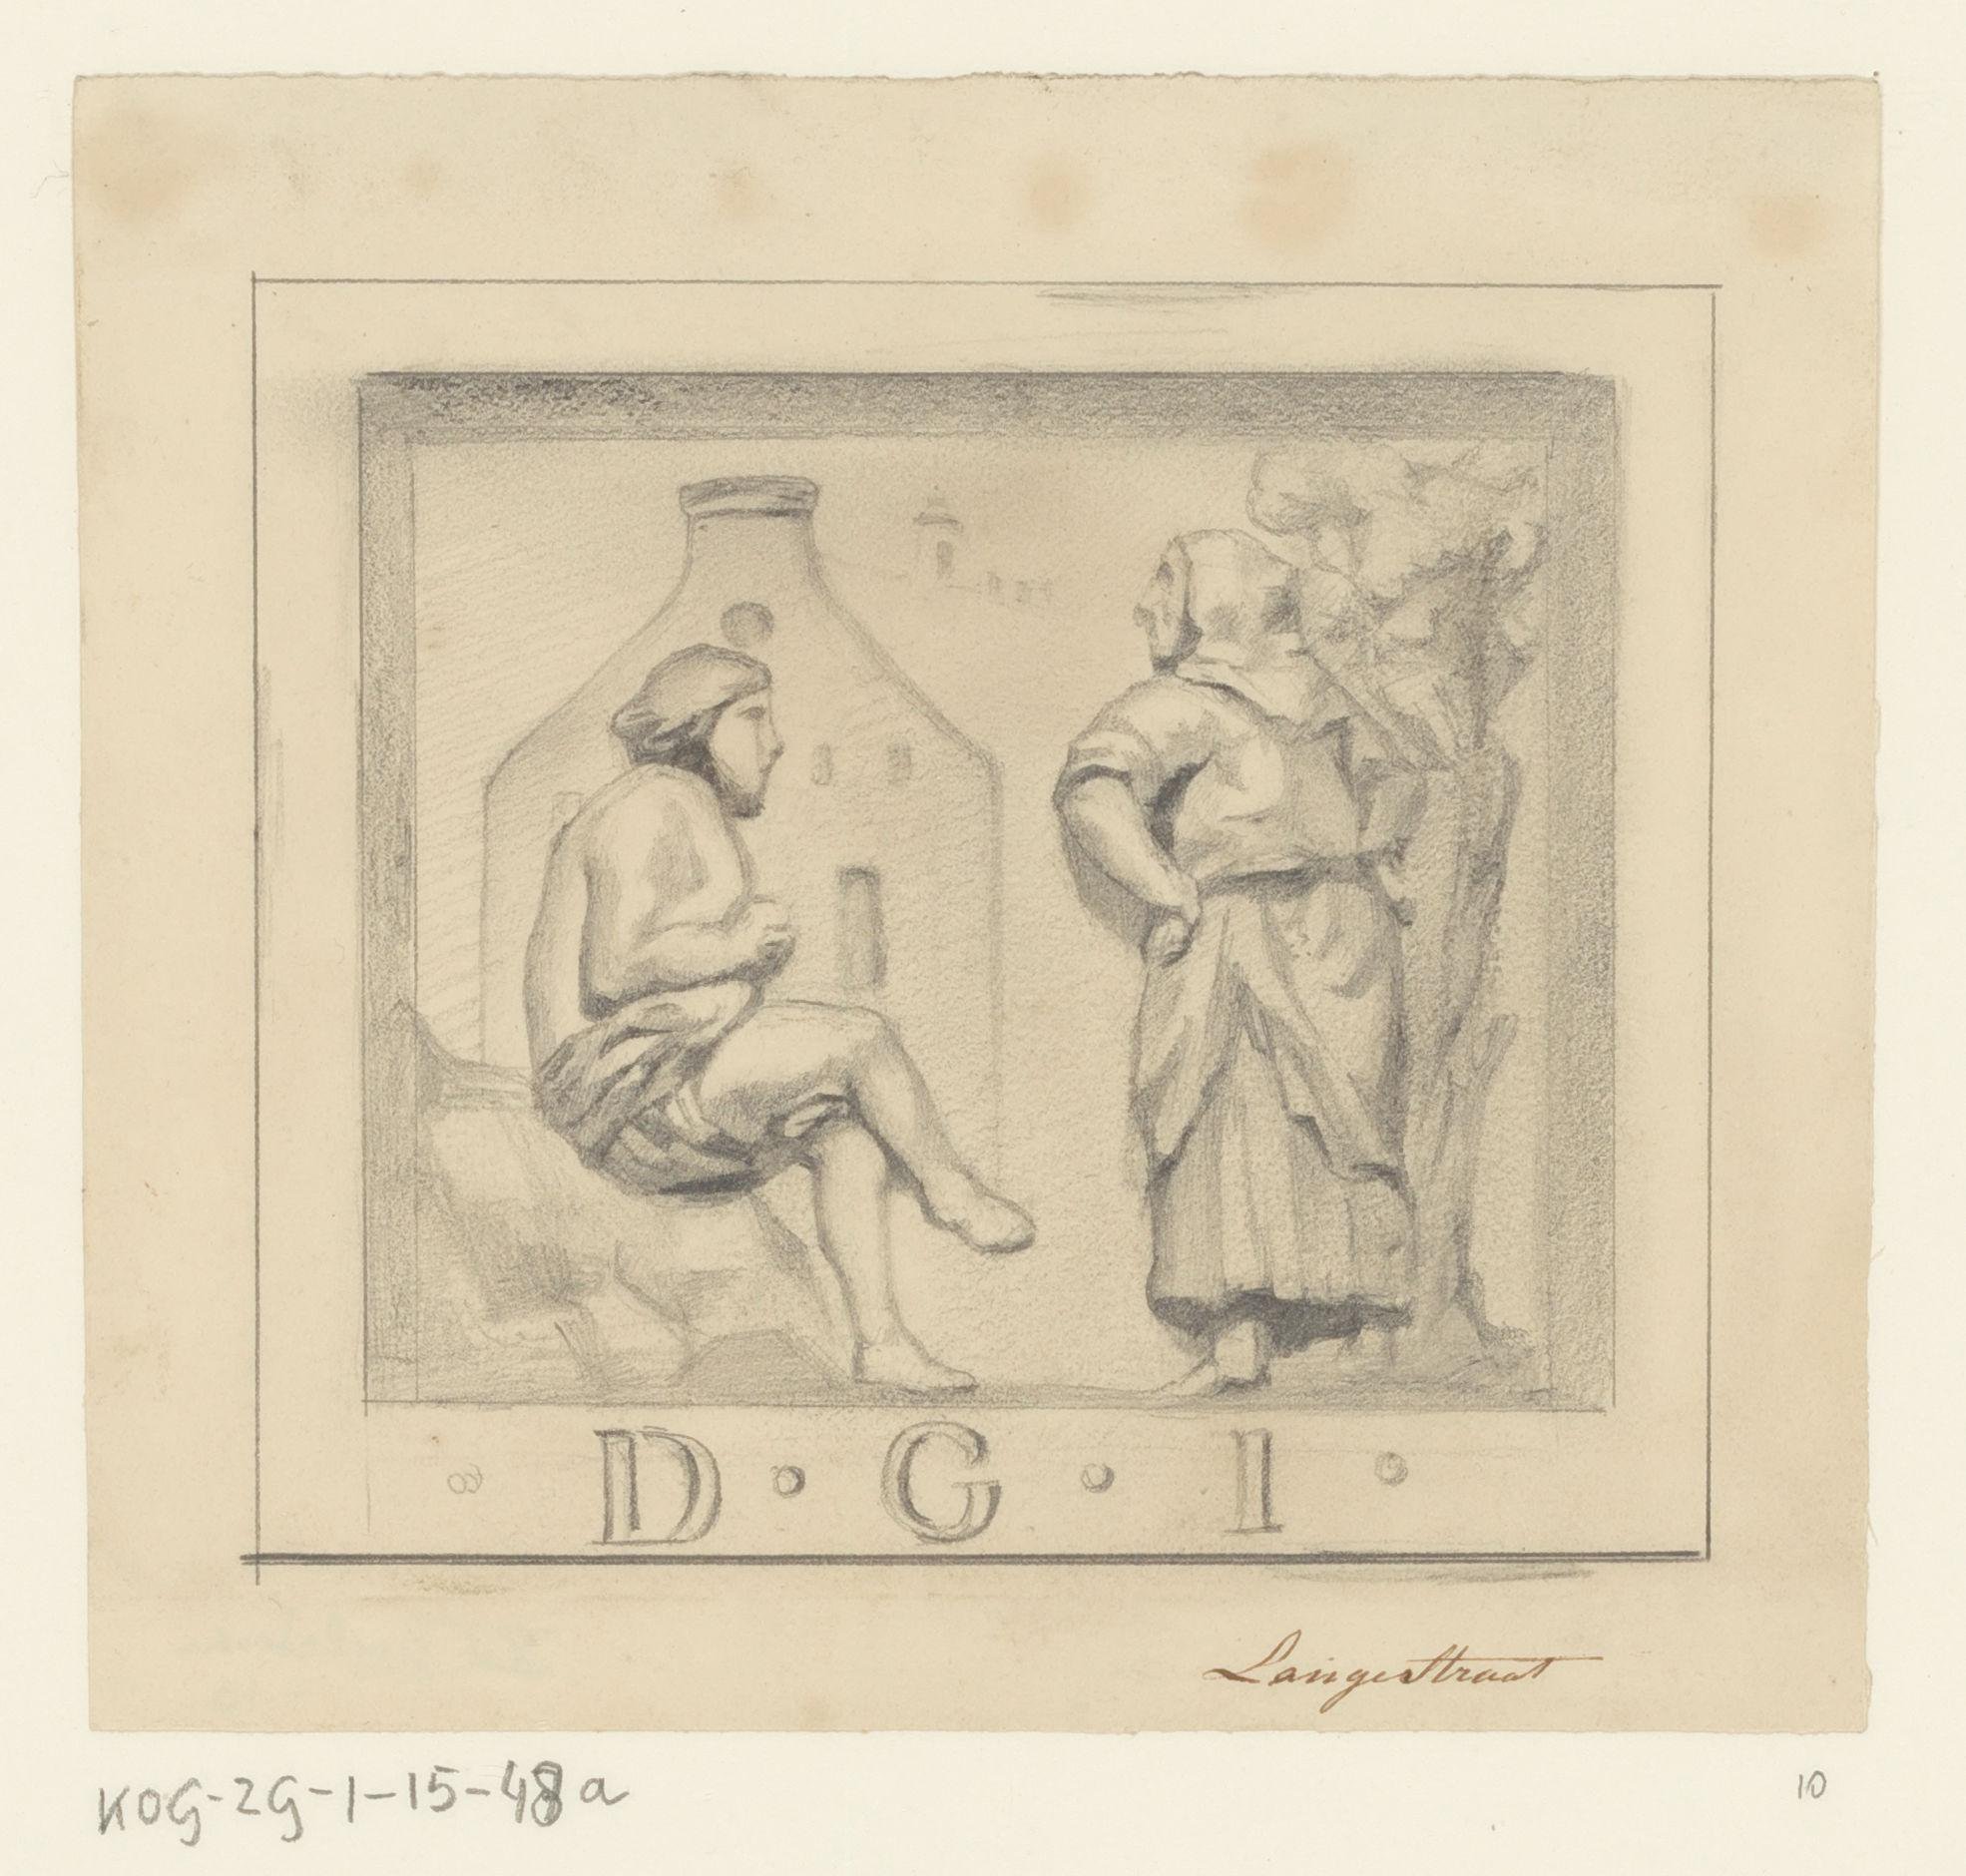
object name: drawing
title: Gevelsteen met een staande man en een staande vrouw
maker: Anonymous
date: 1800-1899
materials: paper, pencil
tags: stone tablet in façade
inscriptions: collector's mark: Lugt 1641, stamp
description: Gevelsteen met een staande man en een staande vrouw. Onderaan de letters: D.G.I. Mogelijk uit de Langestraat te Amsterdam. Onderwerpsrubrieken binnen de Atlas Zeden en Gewoonten: Handel, nijverheid en verkeer, Uithangteekens, gevelstenen.